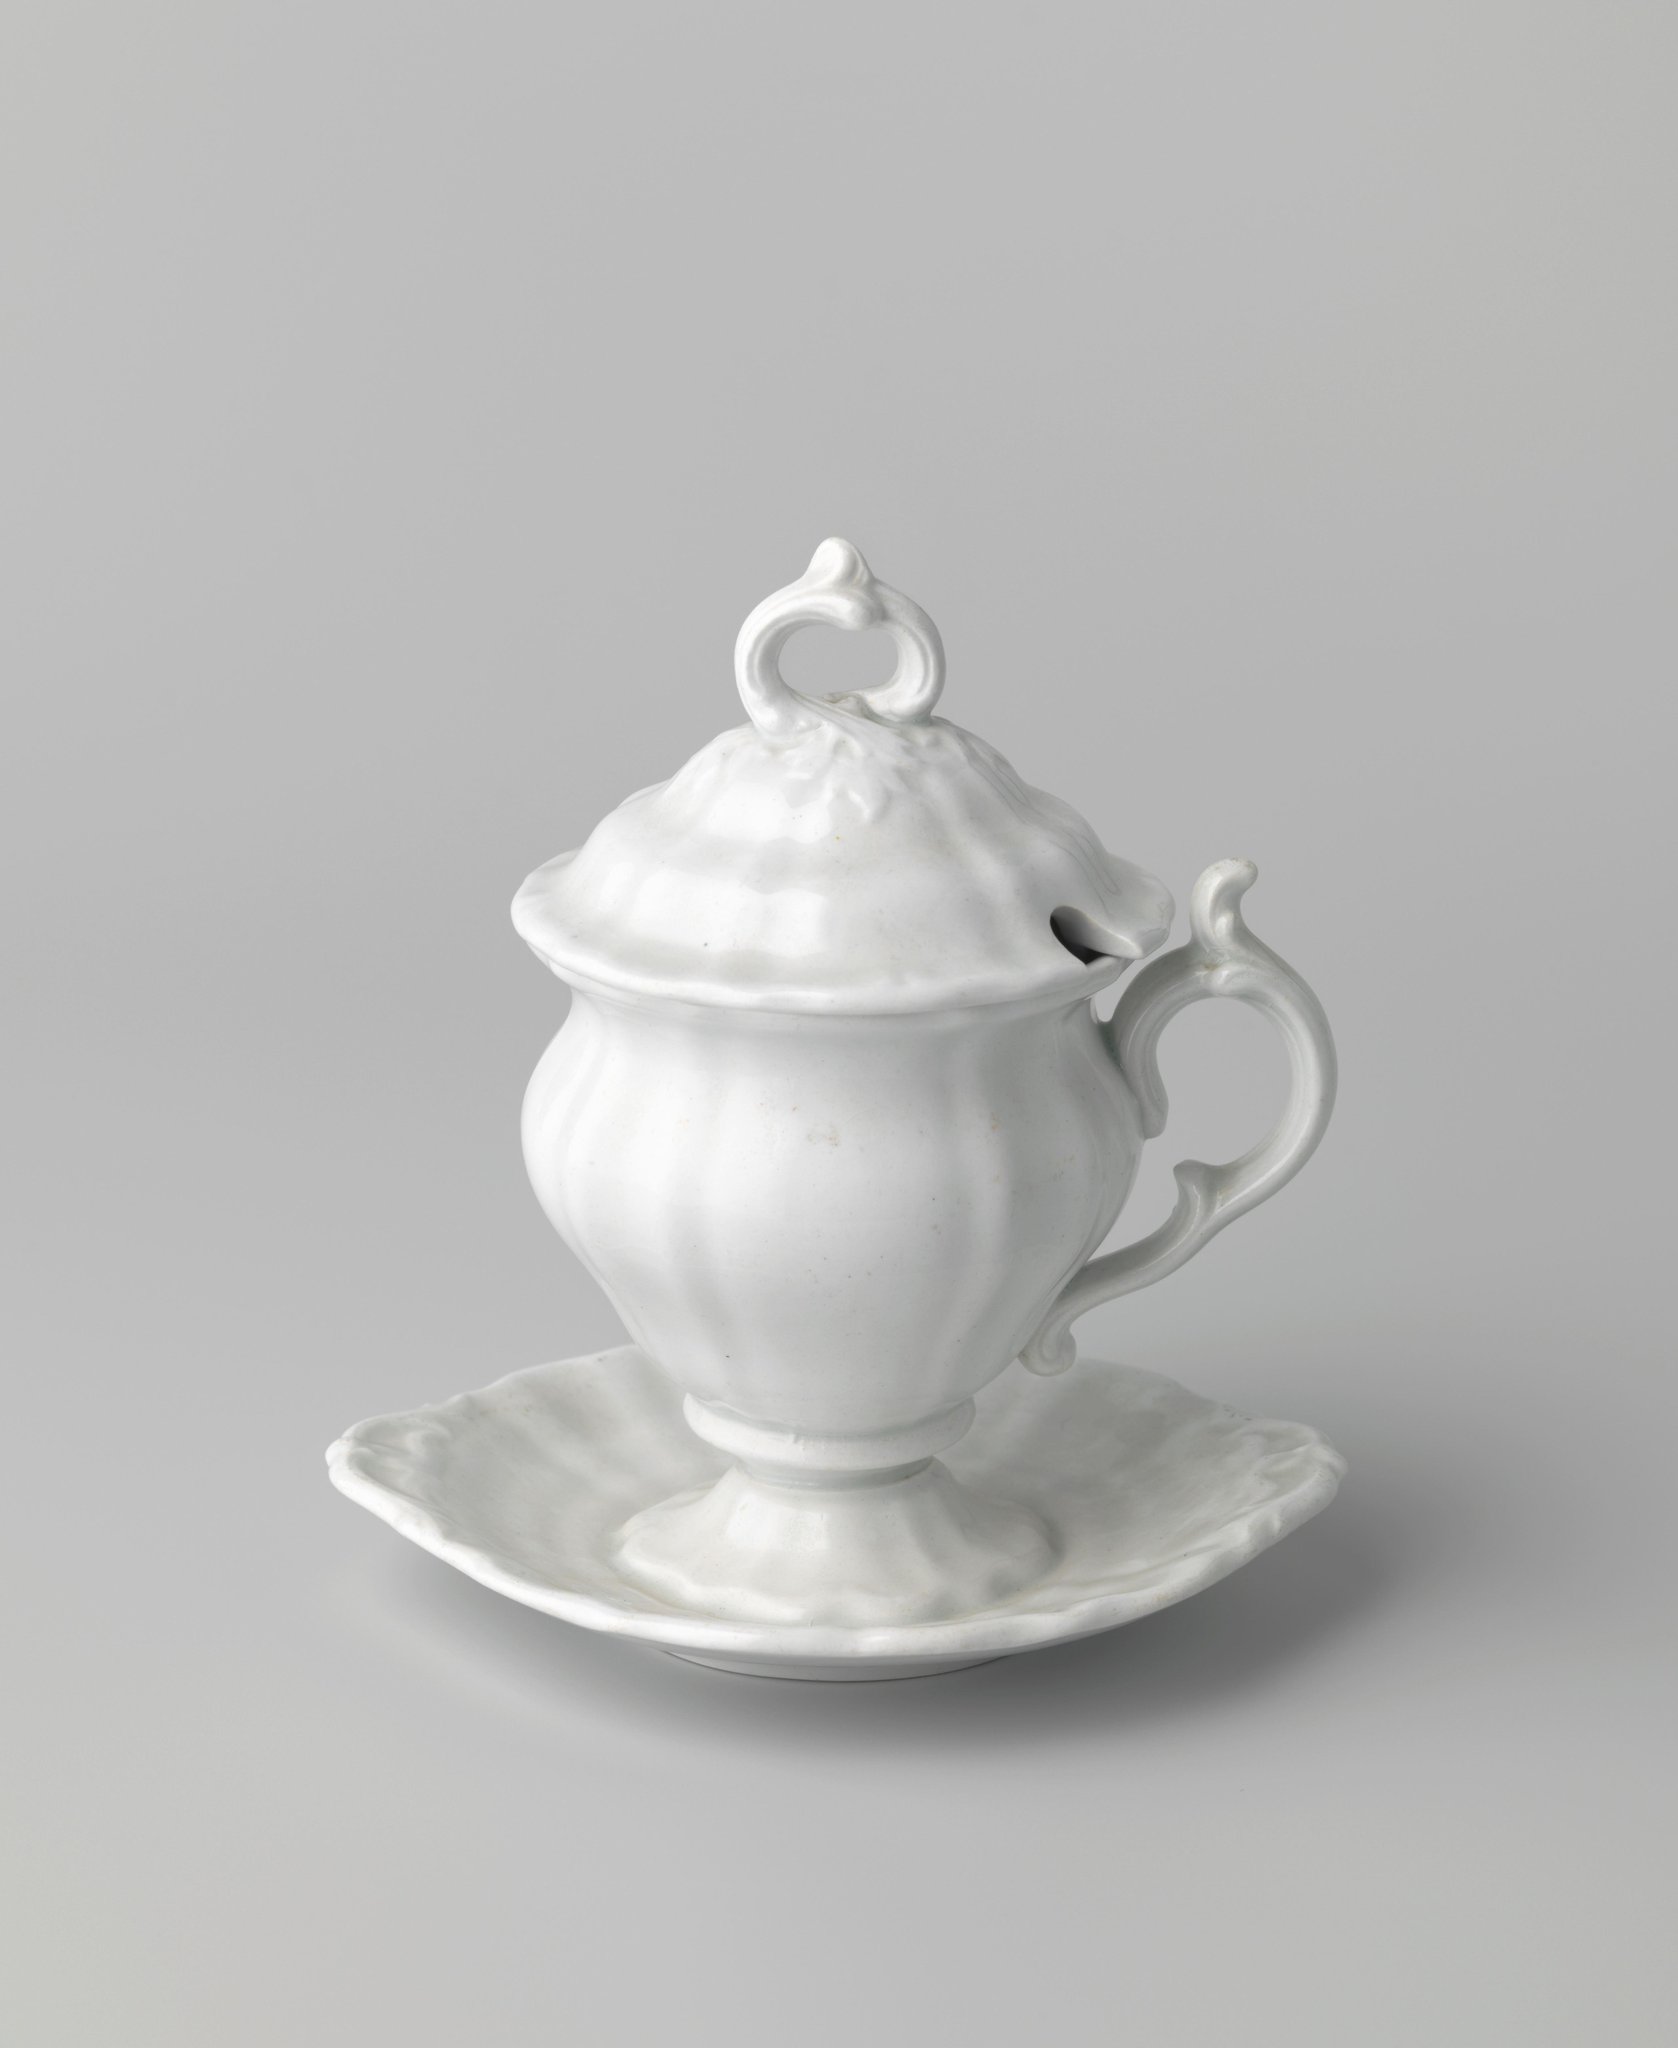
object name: mustard pot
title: Mosterdpot op voet en met vaste onderschotel, wit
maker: petrus regout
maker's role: plateelbakker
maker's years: 1801-1879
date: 1860-1890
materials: earthenware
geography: maastricht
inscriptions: check stamp: ‘P. REGOUT // MAASTRICHT // 27X’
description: Mosterdpot met deksel, op voet en met een vaste onderschotel van wit graniet-aardewerk. Het trapsgewijs gewelfde deksel wordt bekroond door een knop in de vorm van omgekruld bladwerk.